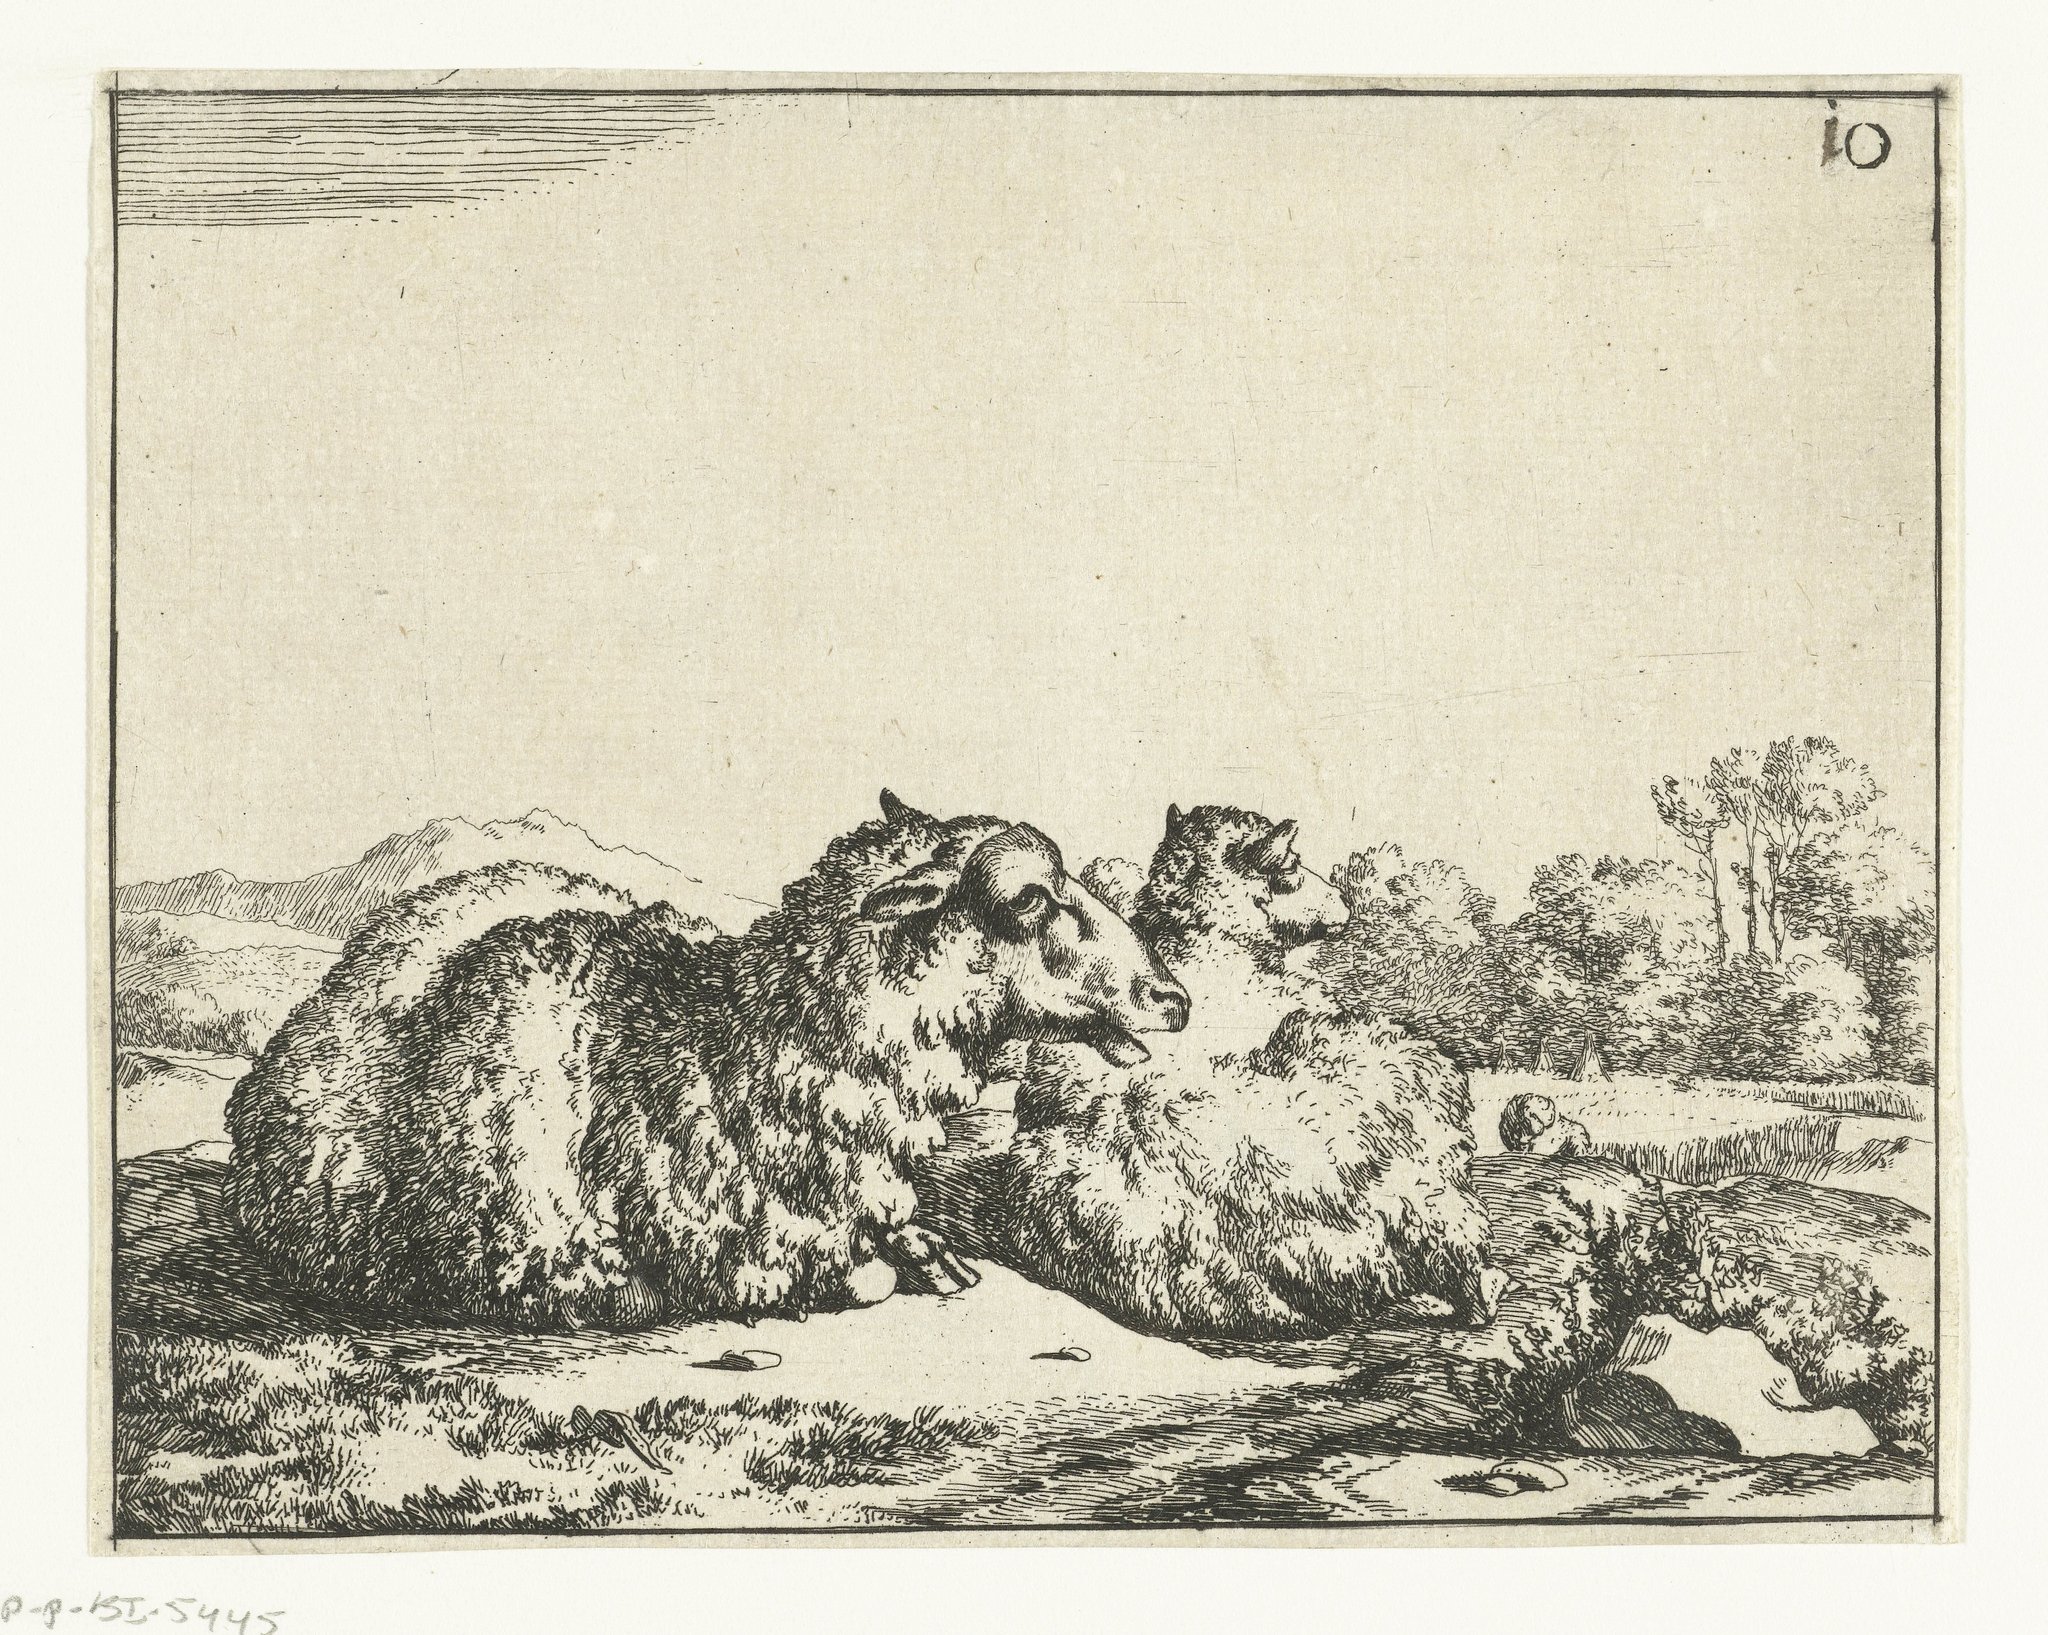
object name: print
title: Schapen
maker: marcus de bye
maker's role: print maker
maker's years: 1639-1688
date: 1664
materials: paper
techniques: etching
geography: the hague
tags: sheep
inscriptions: collector's mark: Lugt 2228